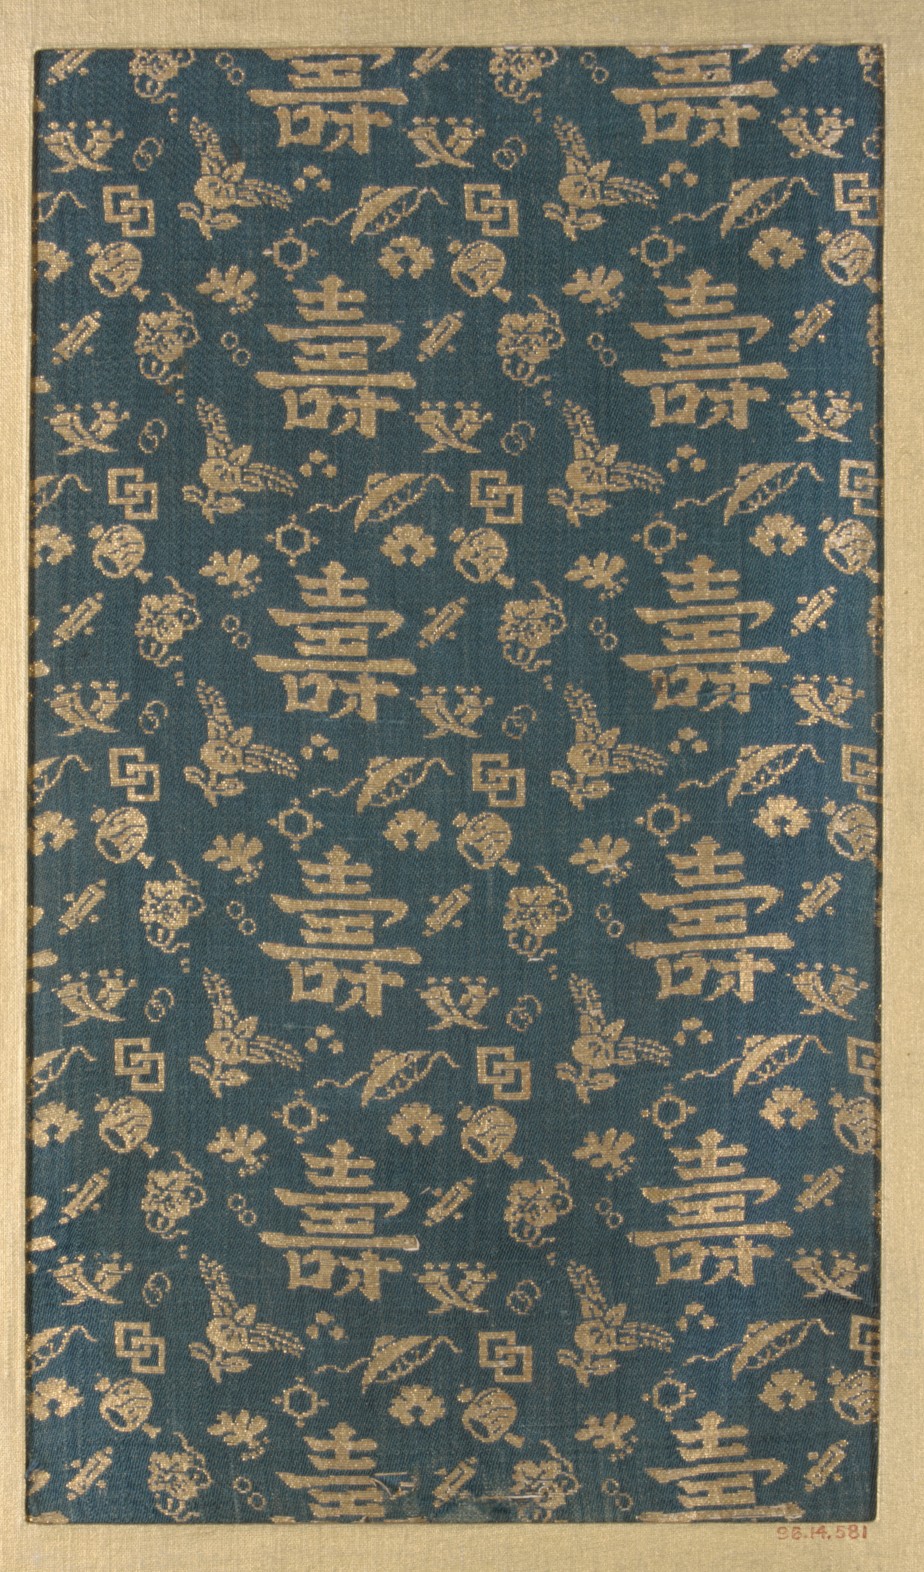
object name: piece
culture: japanese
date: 1701-1900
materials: silk